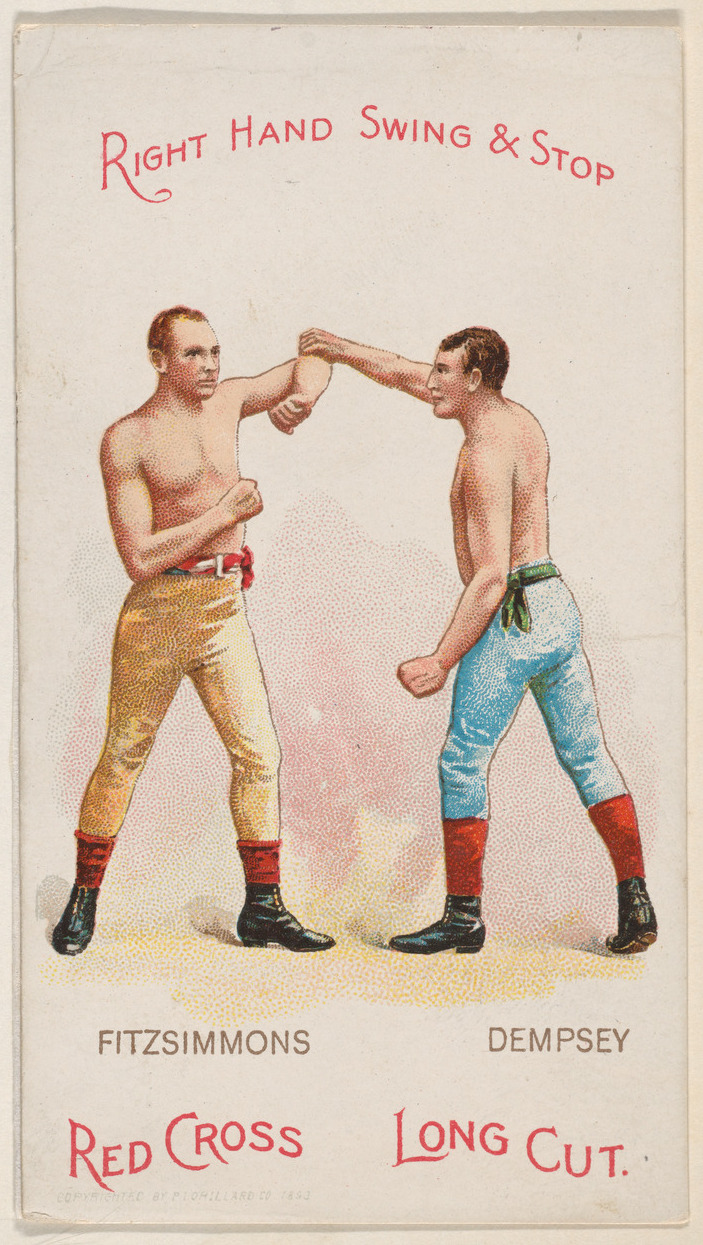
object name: print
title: Right Hand Swing and Stop, Bob Fitzsimmons and Jack Dempsey, from the Boxing Positions and Boxers series (N266) issued by P. Lorillard Company to promote Red Cross Long Cut Tobacco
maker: p. lorillard company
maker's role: publisher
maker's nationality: american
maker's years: 1760-2014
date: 1893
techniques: color lithograph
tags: men,boxing,athletes